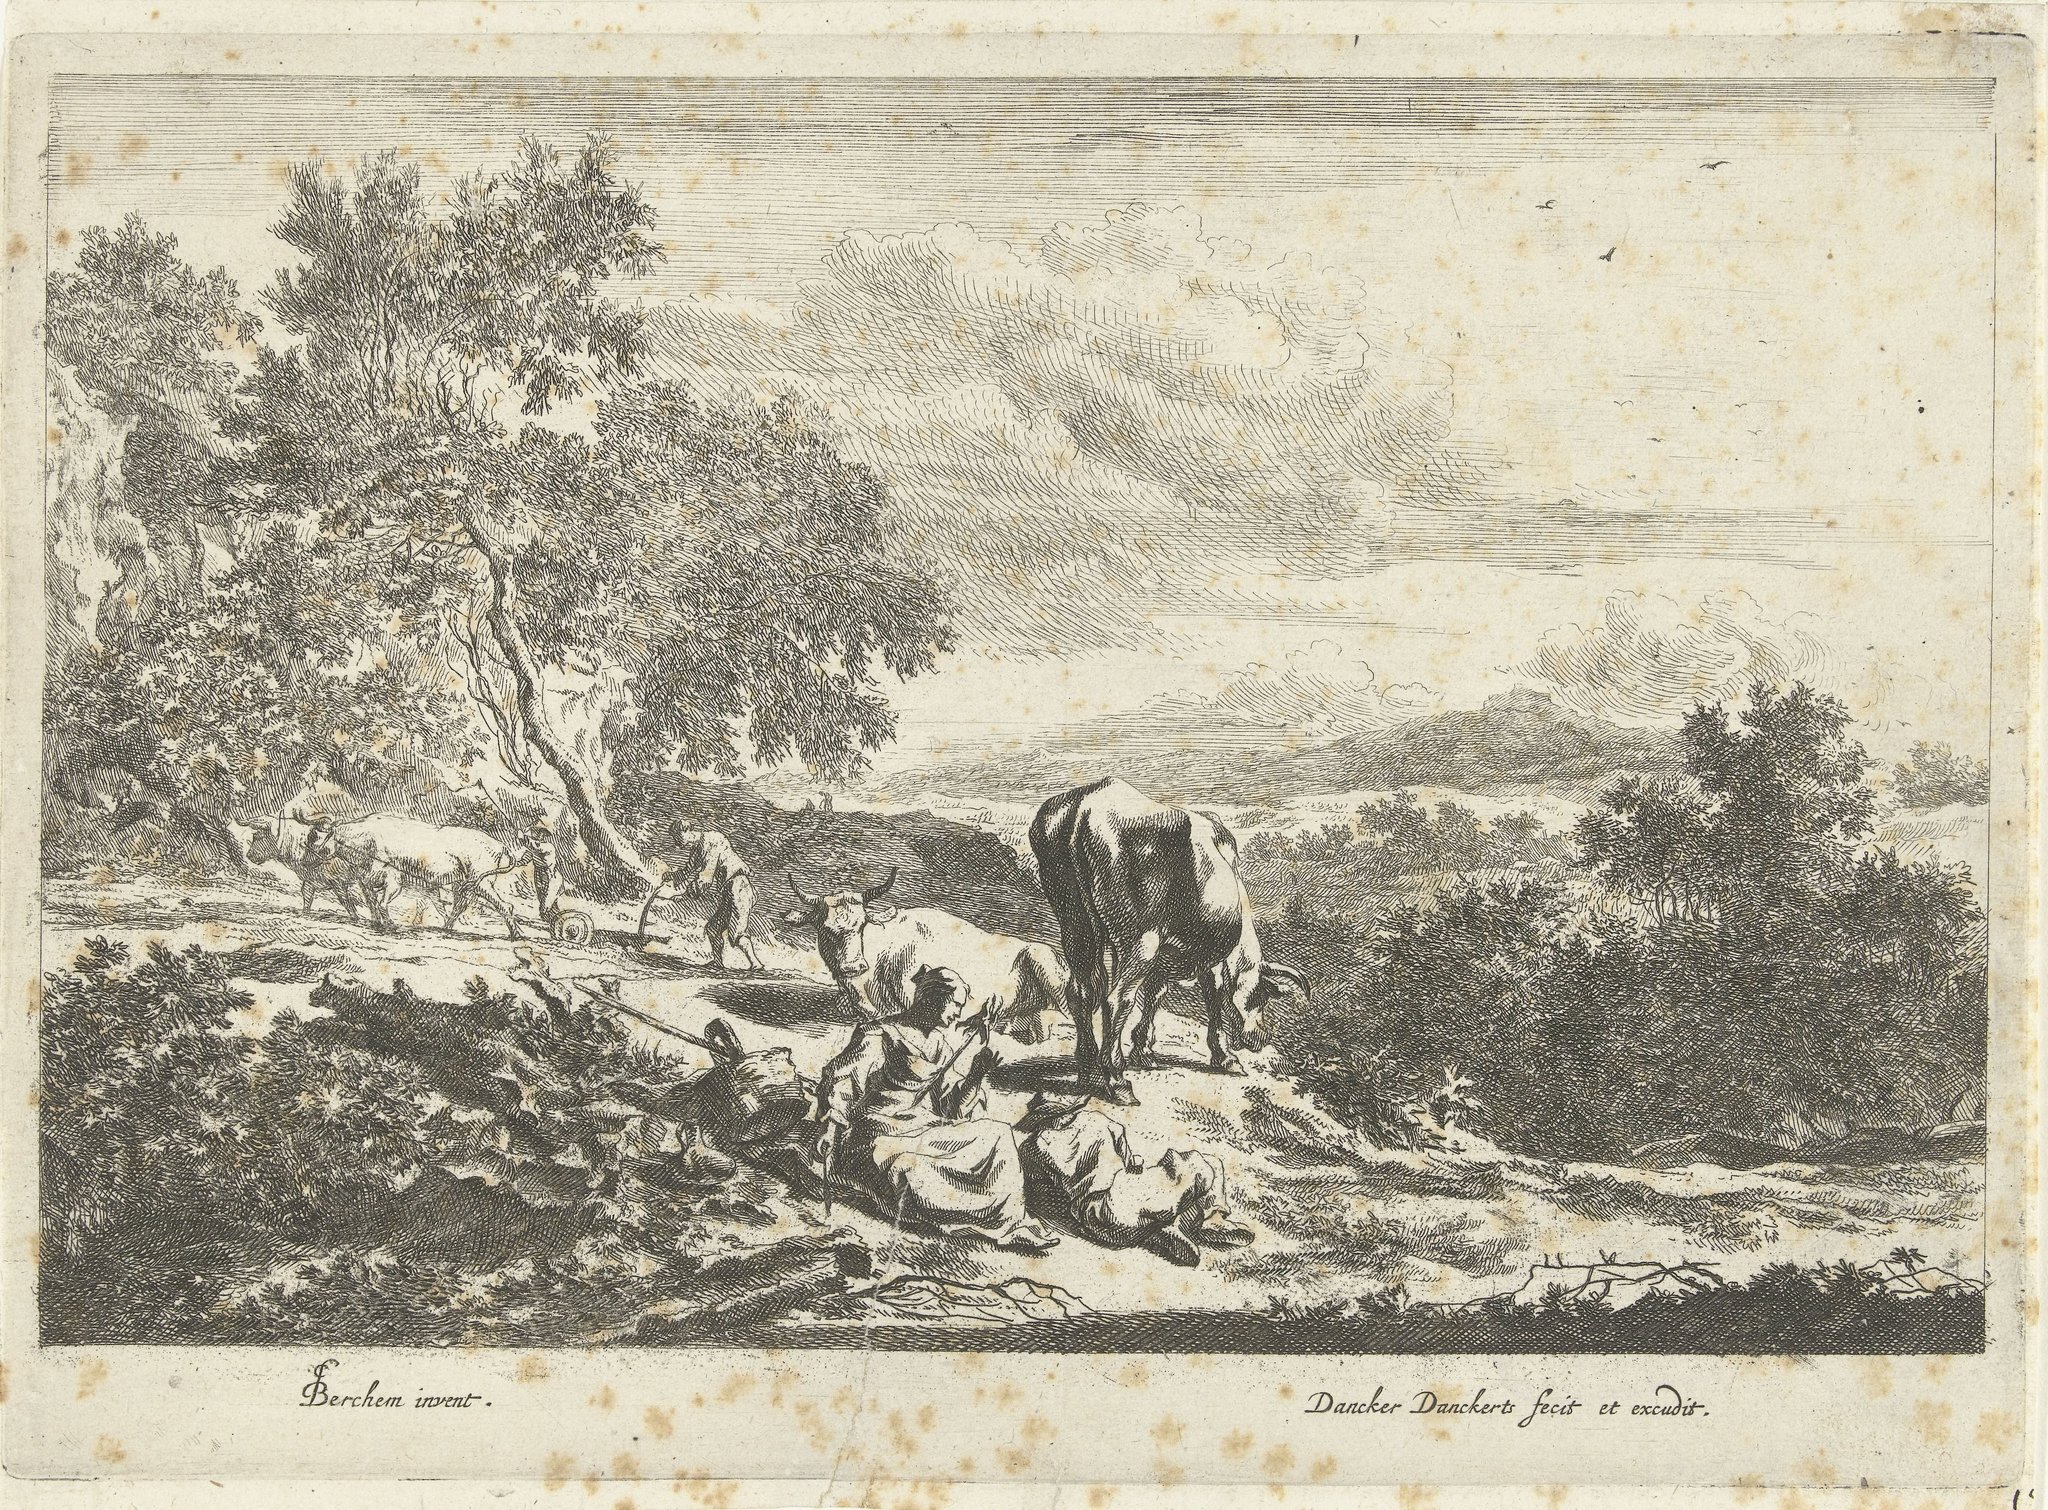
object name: print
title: Italiaanse landschappen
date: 1643-1666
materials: paper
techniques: etching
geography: amsterdam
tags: herding, herdsman, herdswoman, shepherd, shepherdess, cowherd, etc., rocks, ploughing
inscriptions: inscription: ‘B -41 N 34-14’, collector's mark: Lugt 11, collector's mark: Lugt 10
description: Italiaans landschap met spinnende vrouw en slapende jongen bij een akker waar een boer ploegt met twee ossen. Prent nummer 3 uit serie van vier prenten met Italiaanse landschappen.